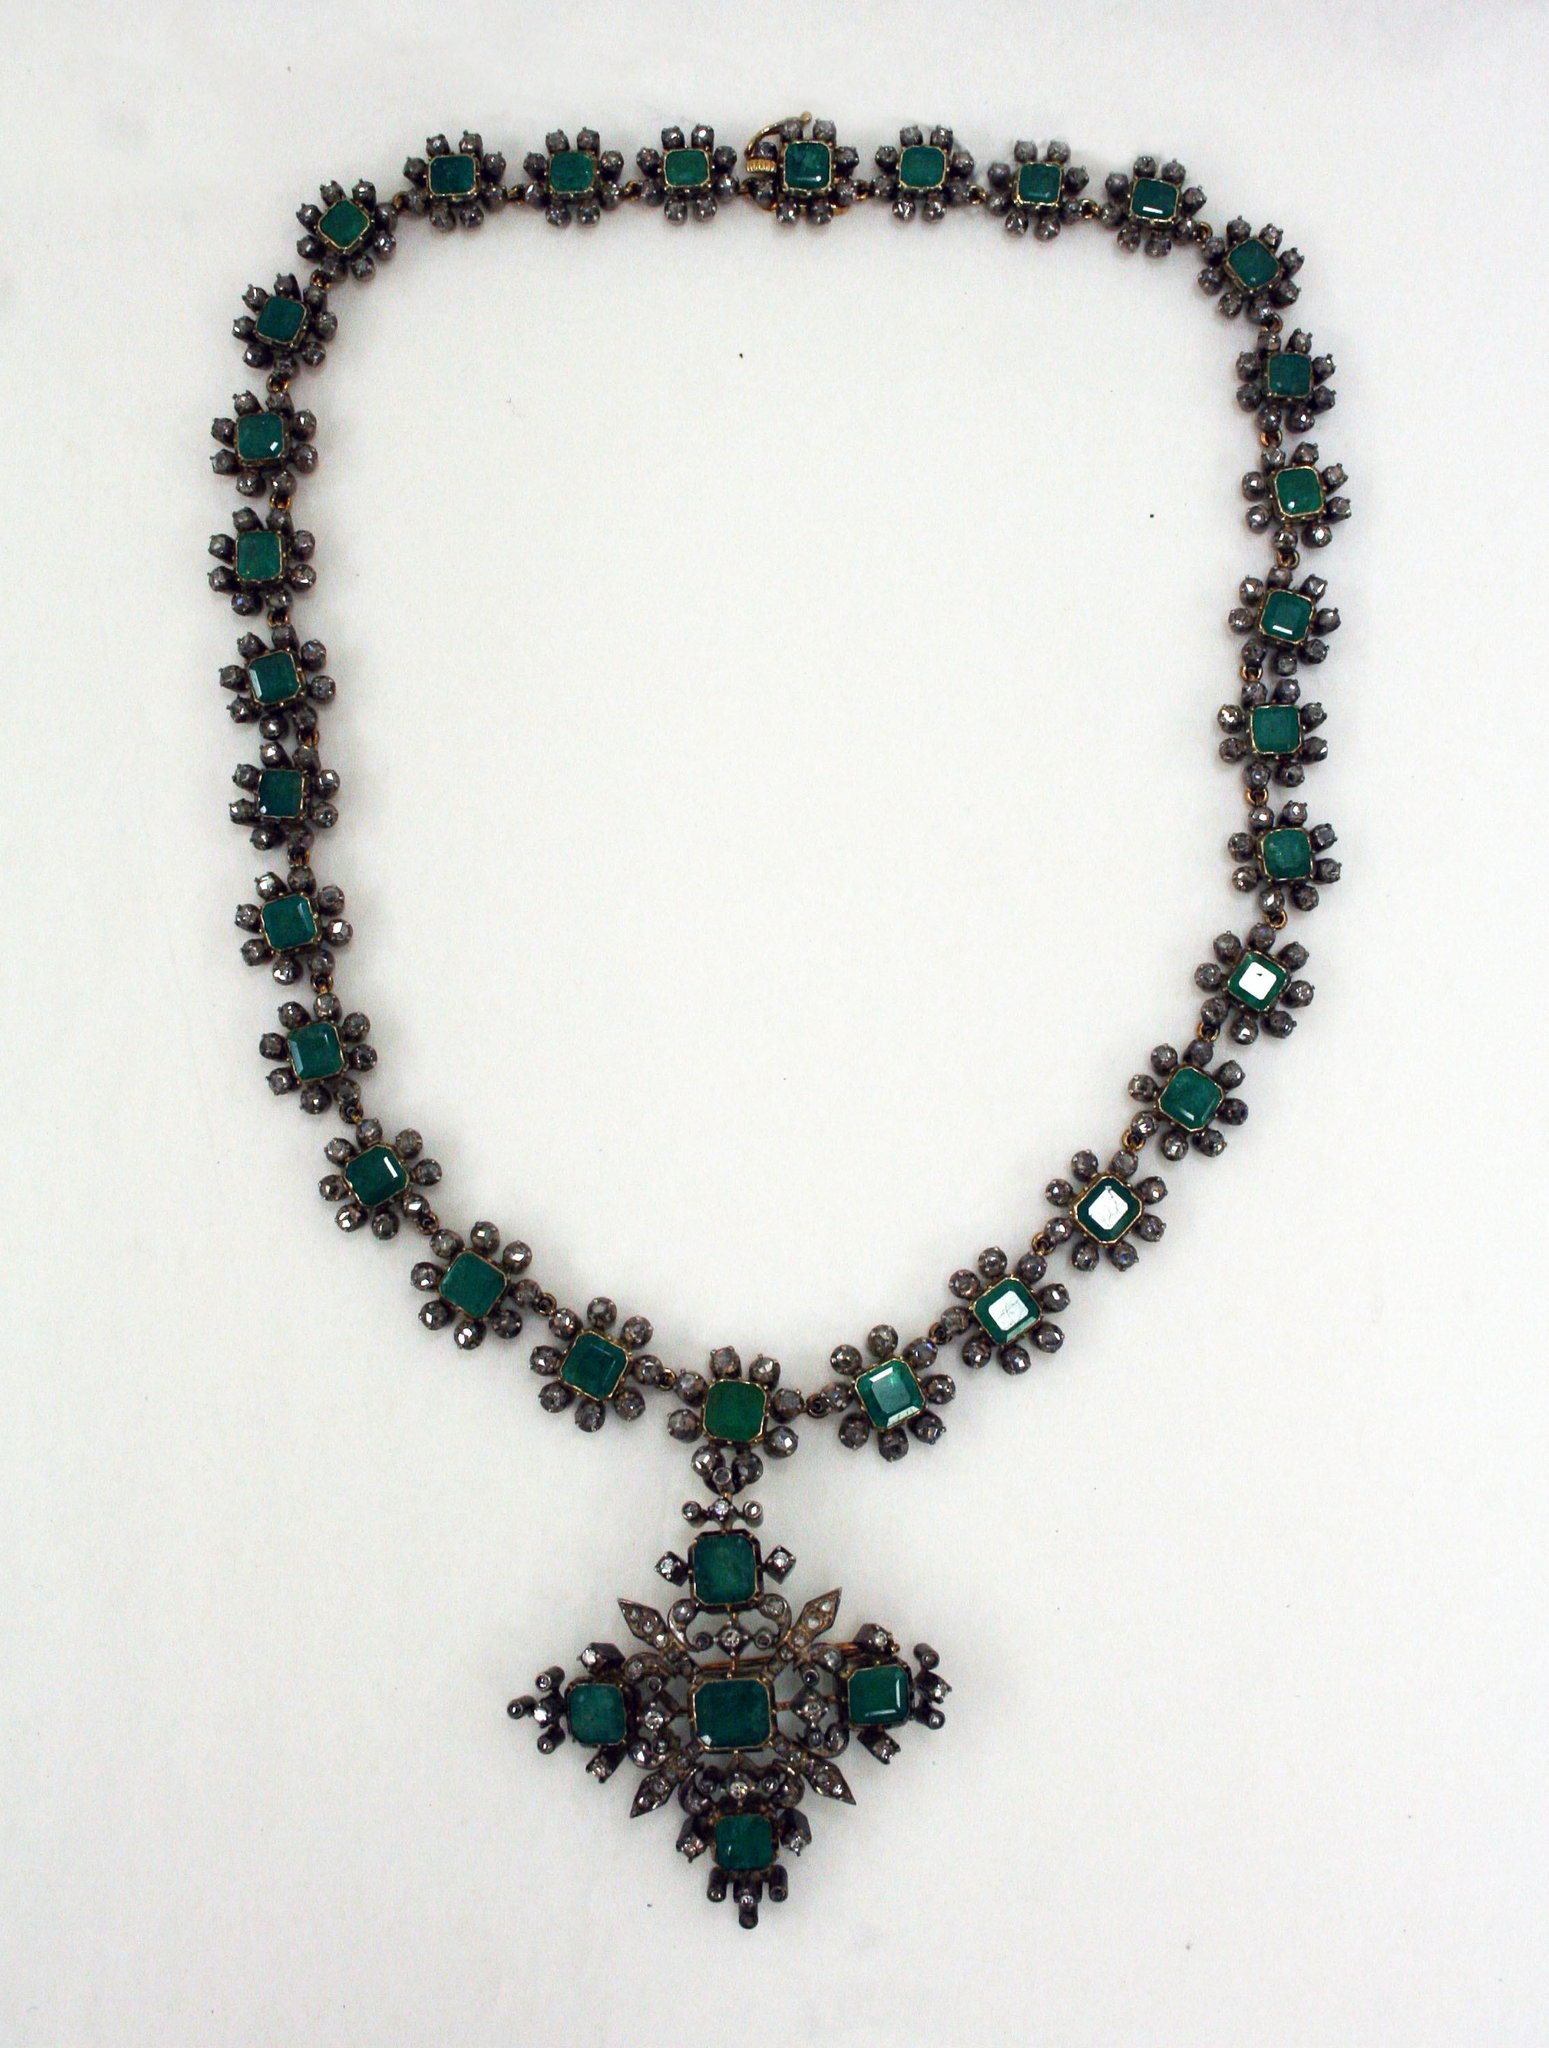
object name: necklace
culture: european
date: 1840-1849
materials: diamond, gemstone, gold